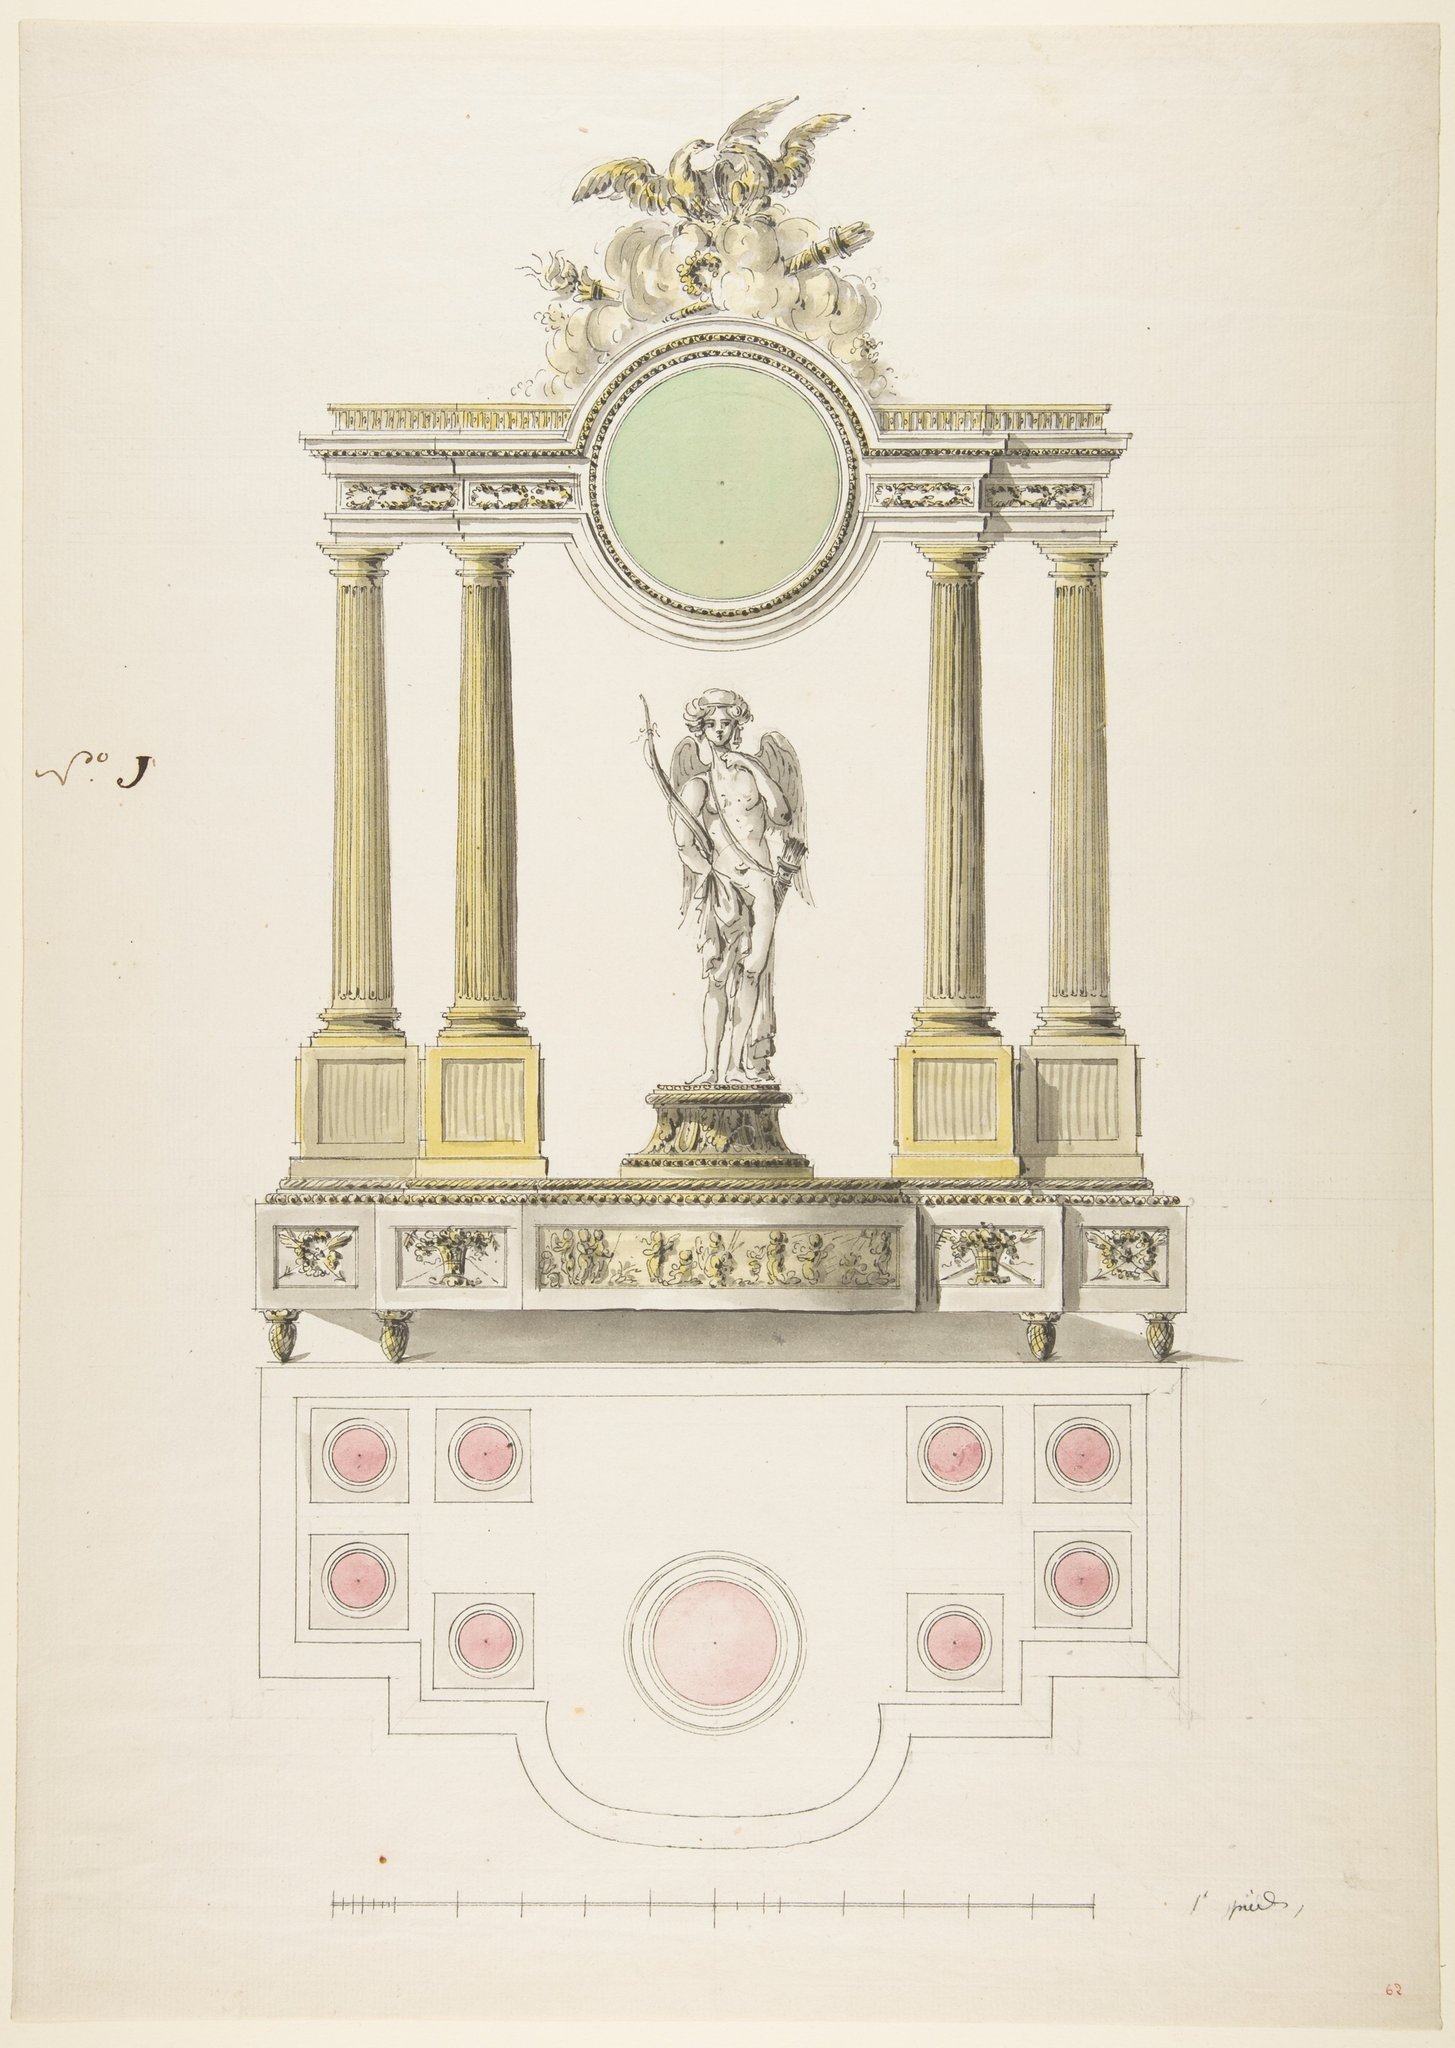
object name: drawing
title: Design for a Clock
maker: anonymous, french, 18th century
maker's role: artist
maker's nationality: french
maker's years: 1700-1800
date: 1770-1790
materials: ink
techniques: brush, pen, wash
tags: clocks